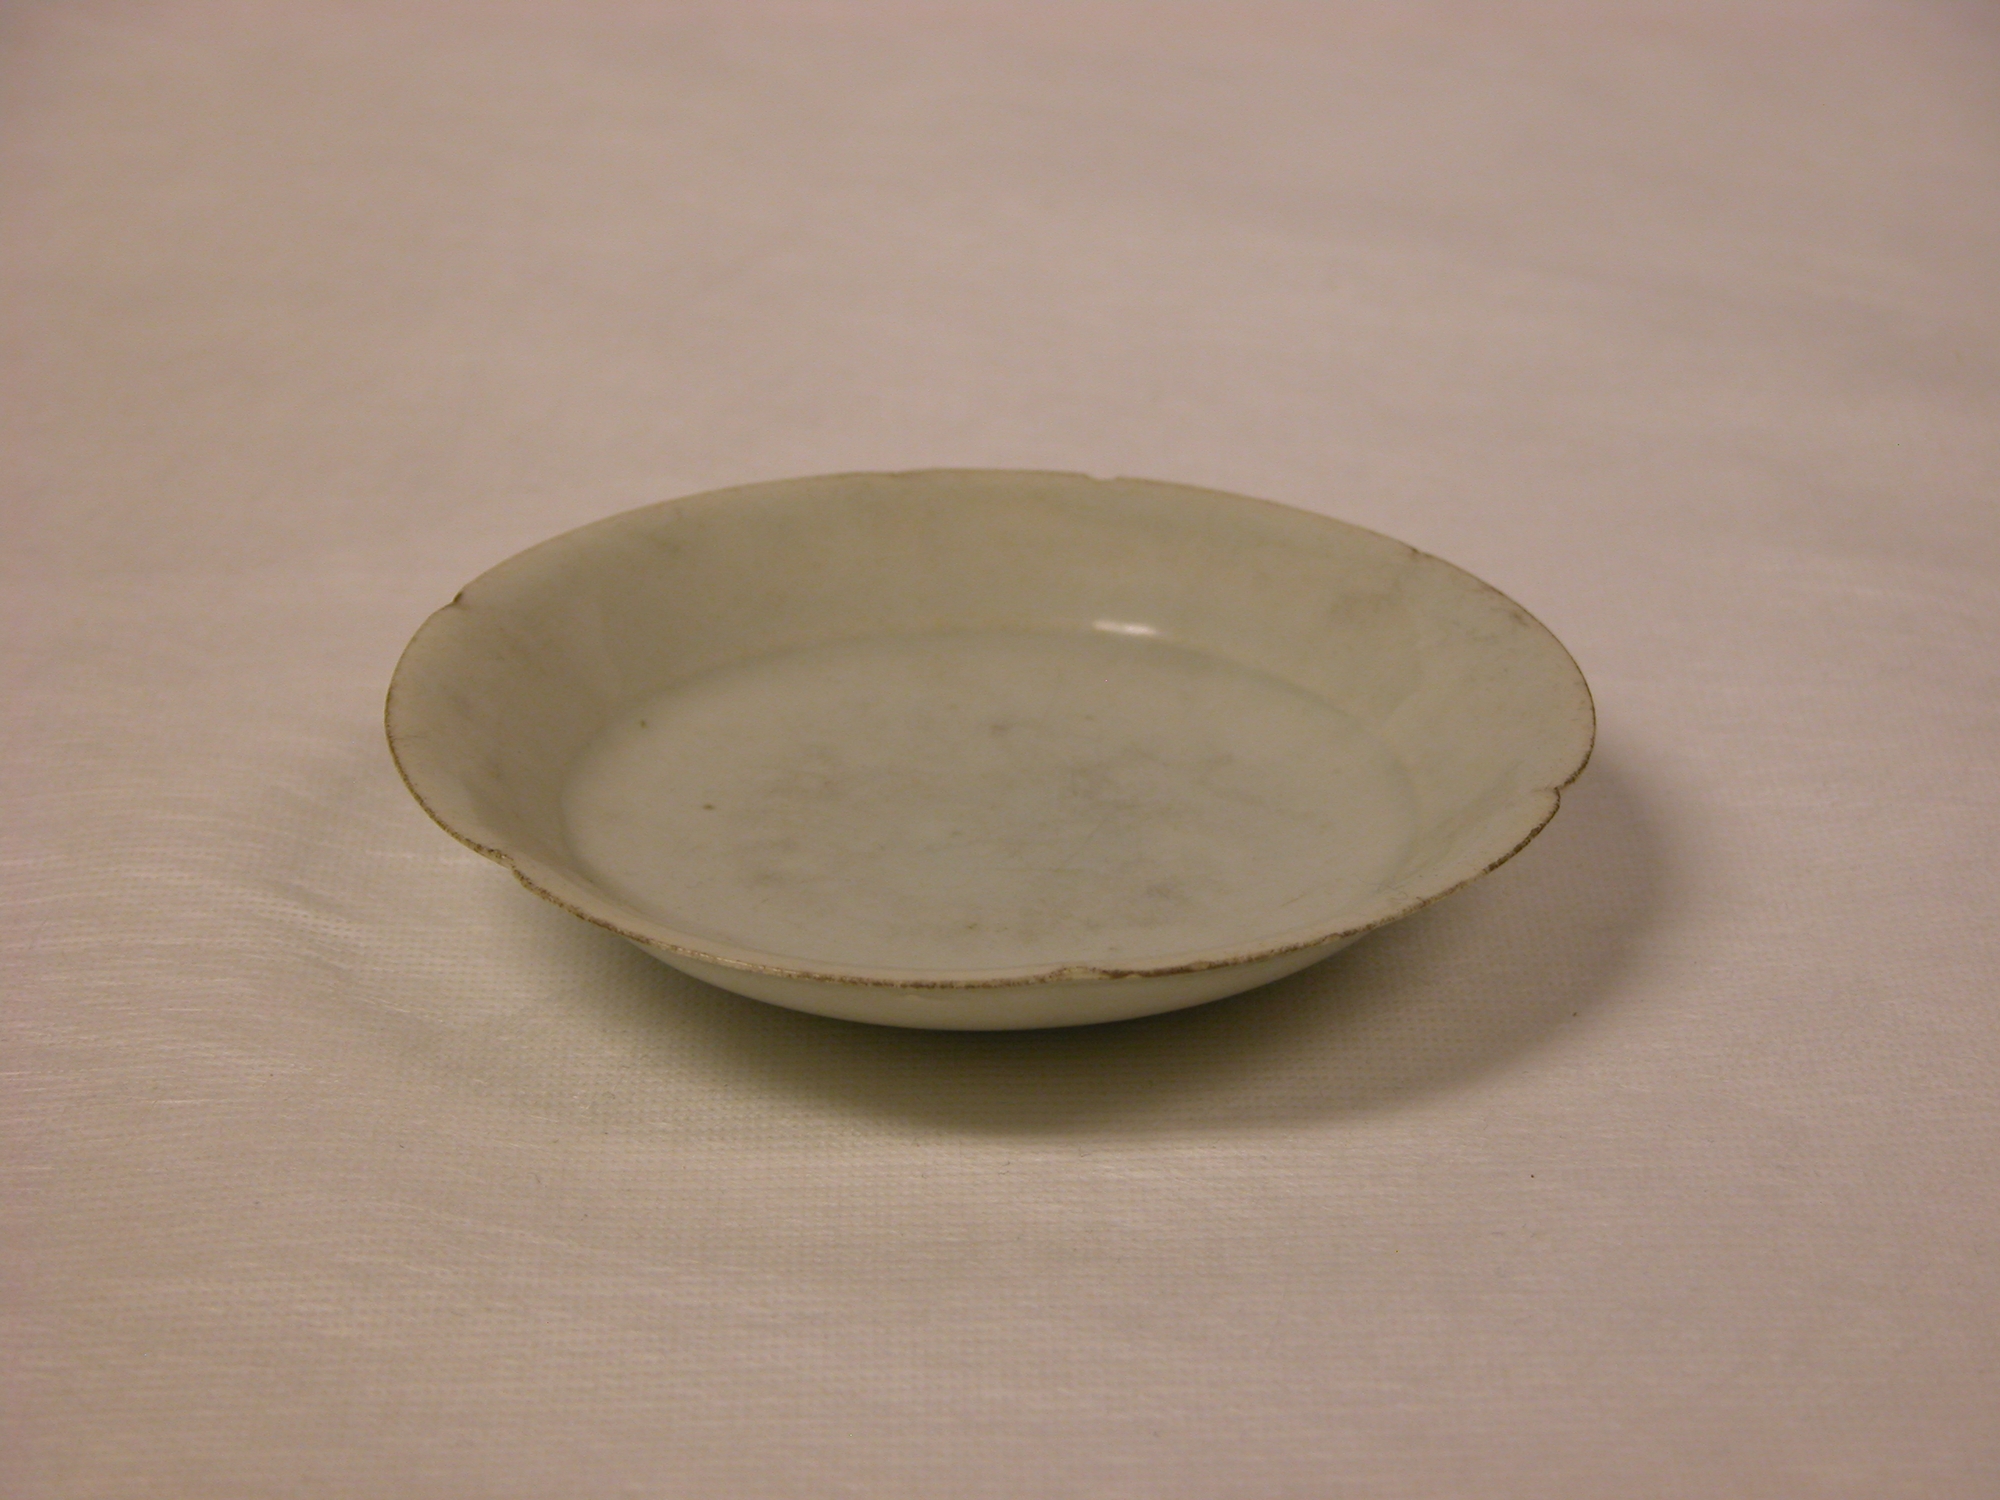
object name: saucer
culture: chinese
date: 960-1279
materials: pottery